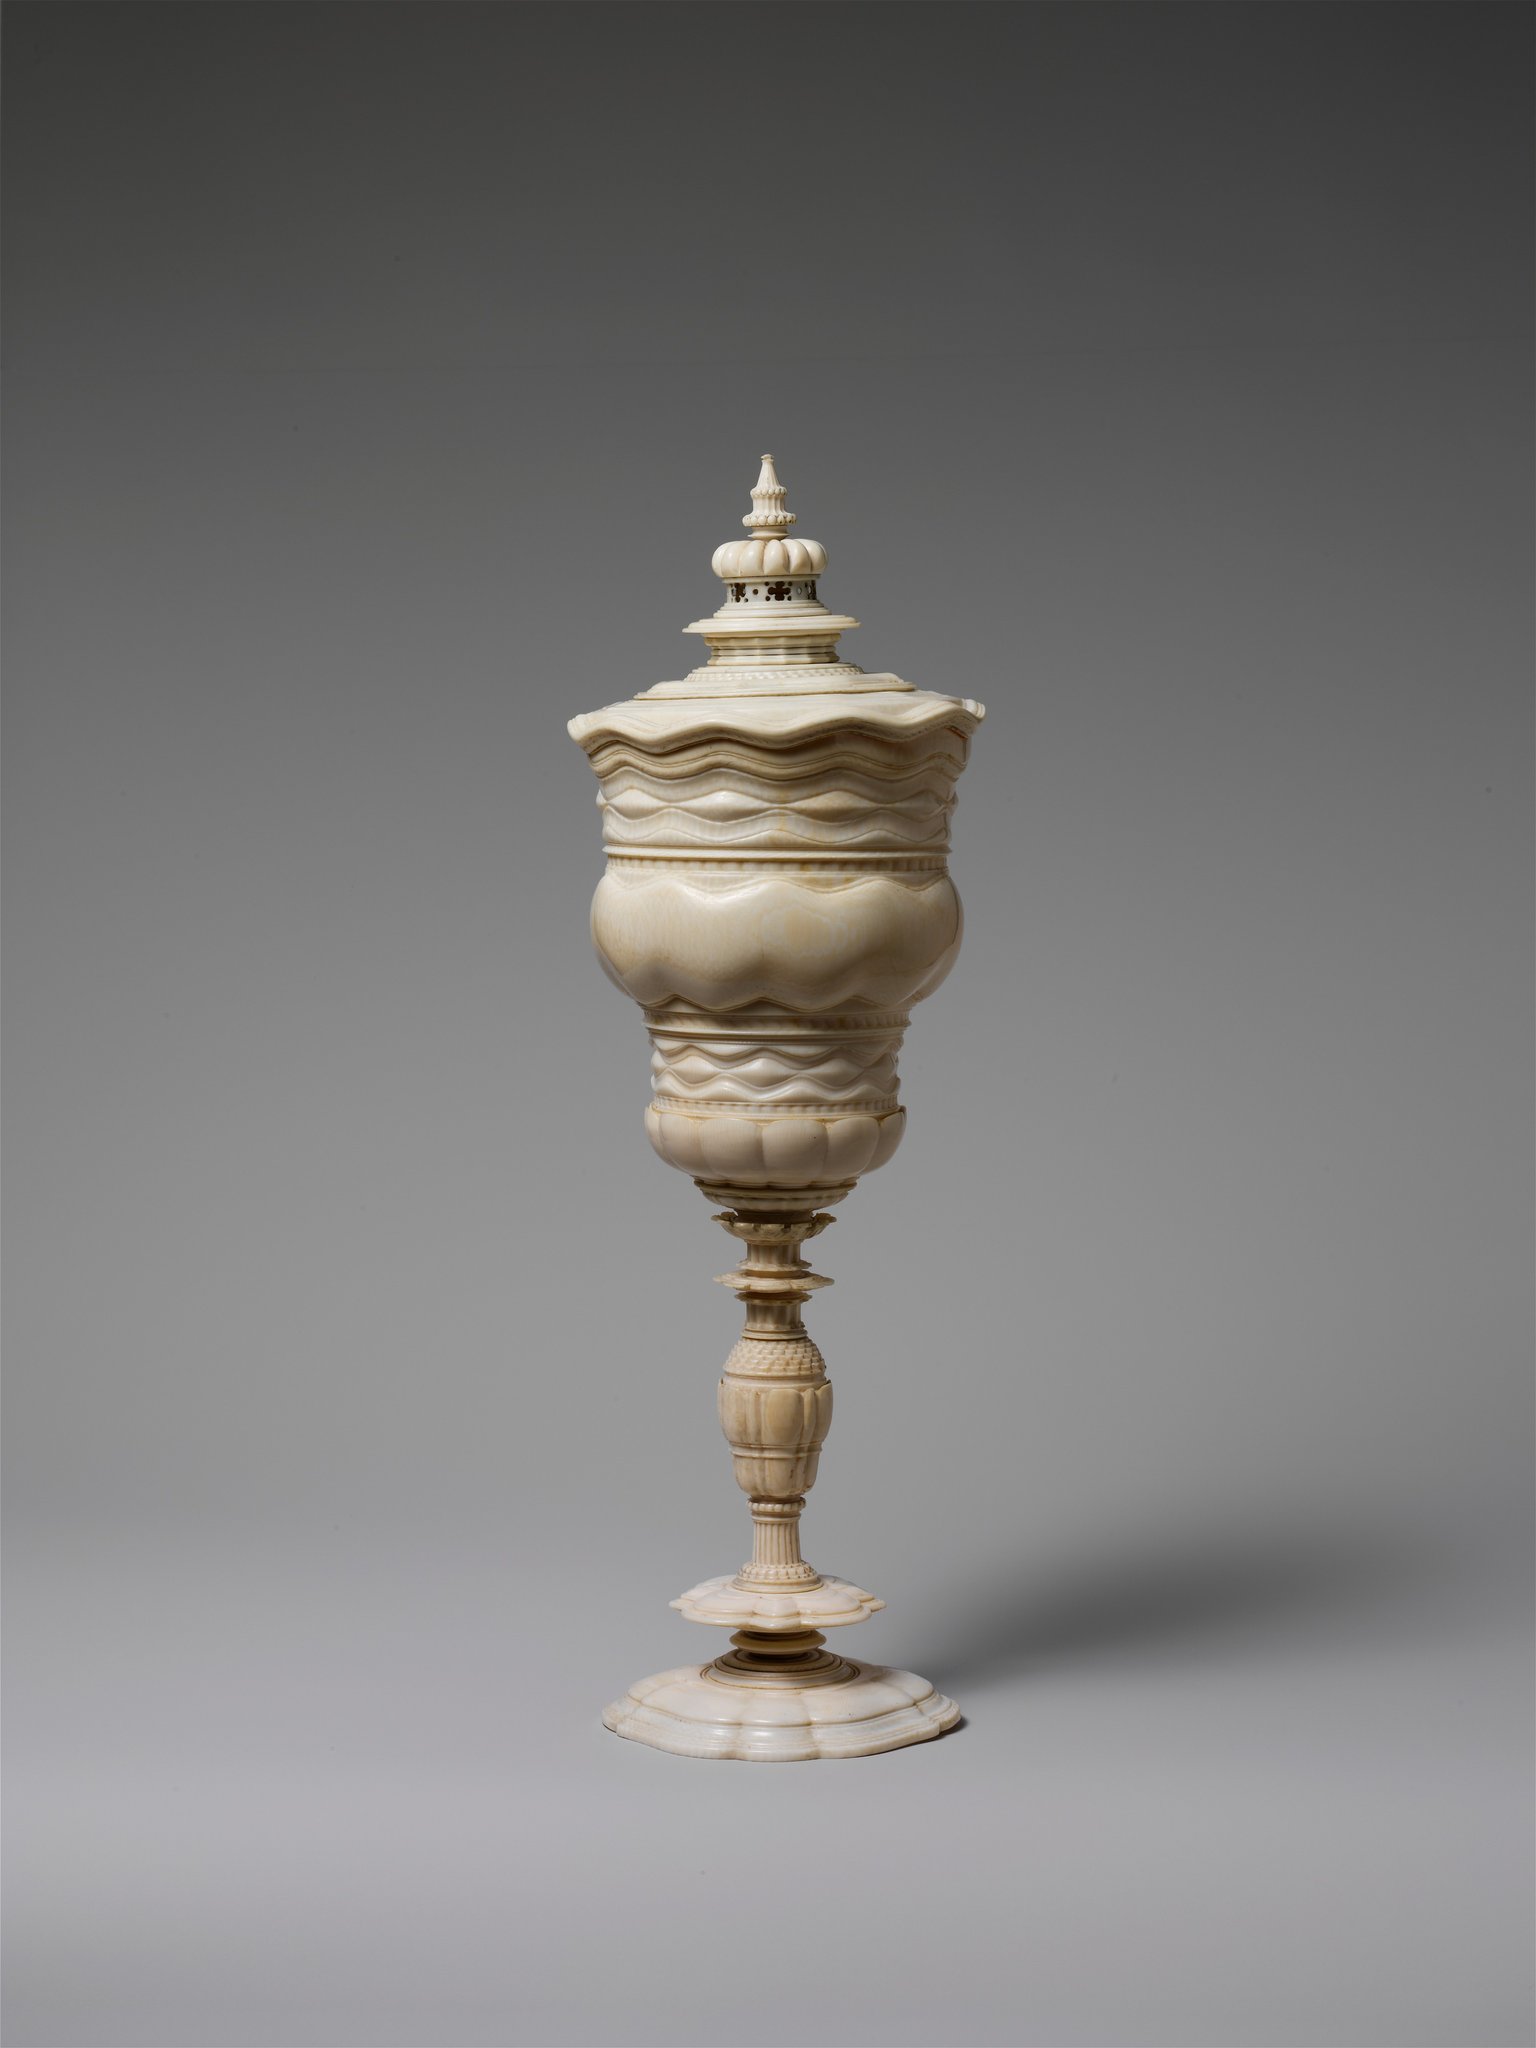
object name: standing cup with cover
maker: lorenz zick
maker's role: maker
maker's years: 1594-1666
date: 1634-1666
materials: ivory